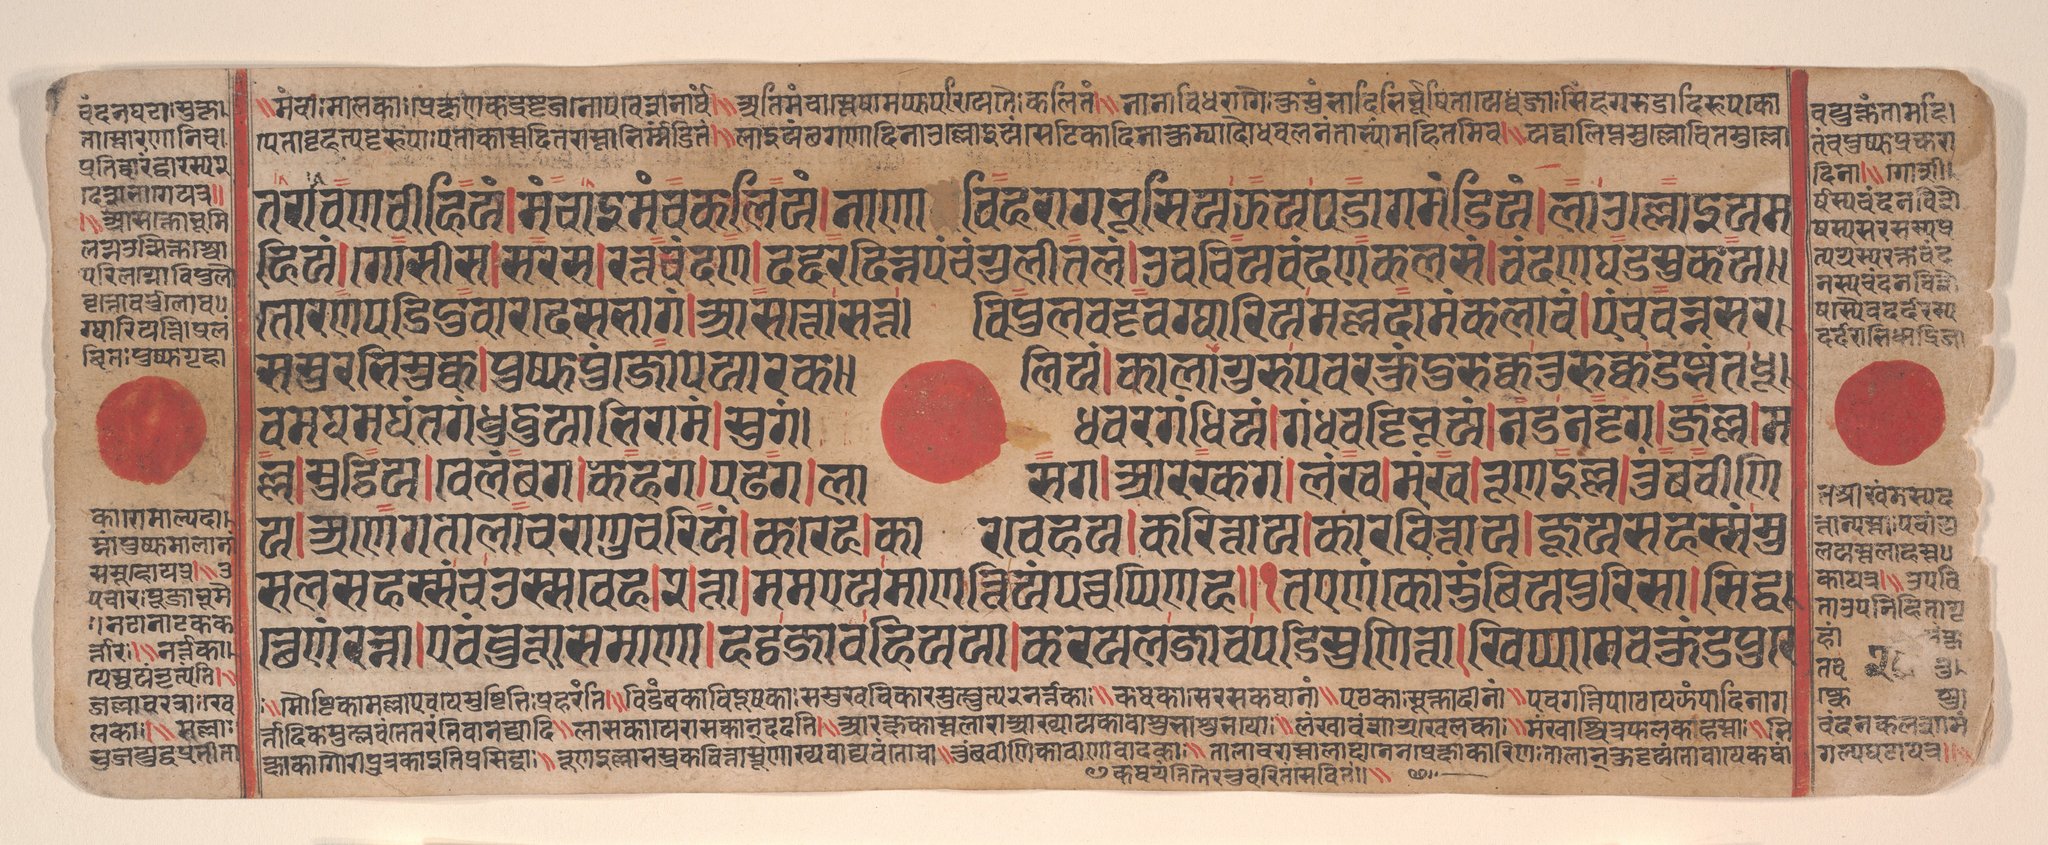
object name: folio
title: Leaf from a Kalpa Sutra (Jain Book of Rituals)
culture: indian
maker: bhadrabahu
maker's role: artist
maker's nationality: indian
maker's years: 356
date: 1401-1500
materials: gold, ink, paper, watercolor